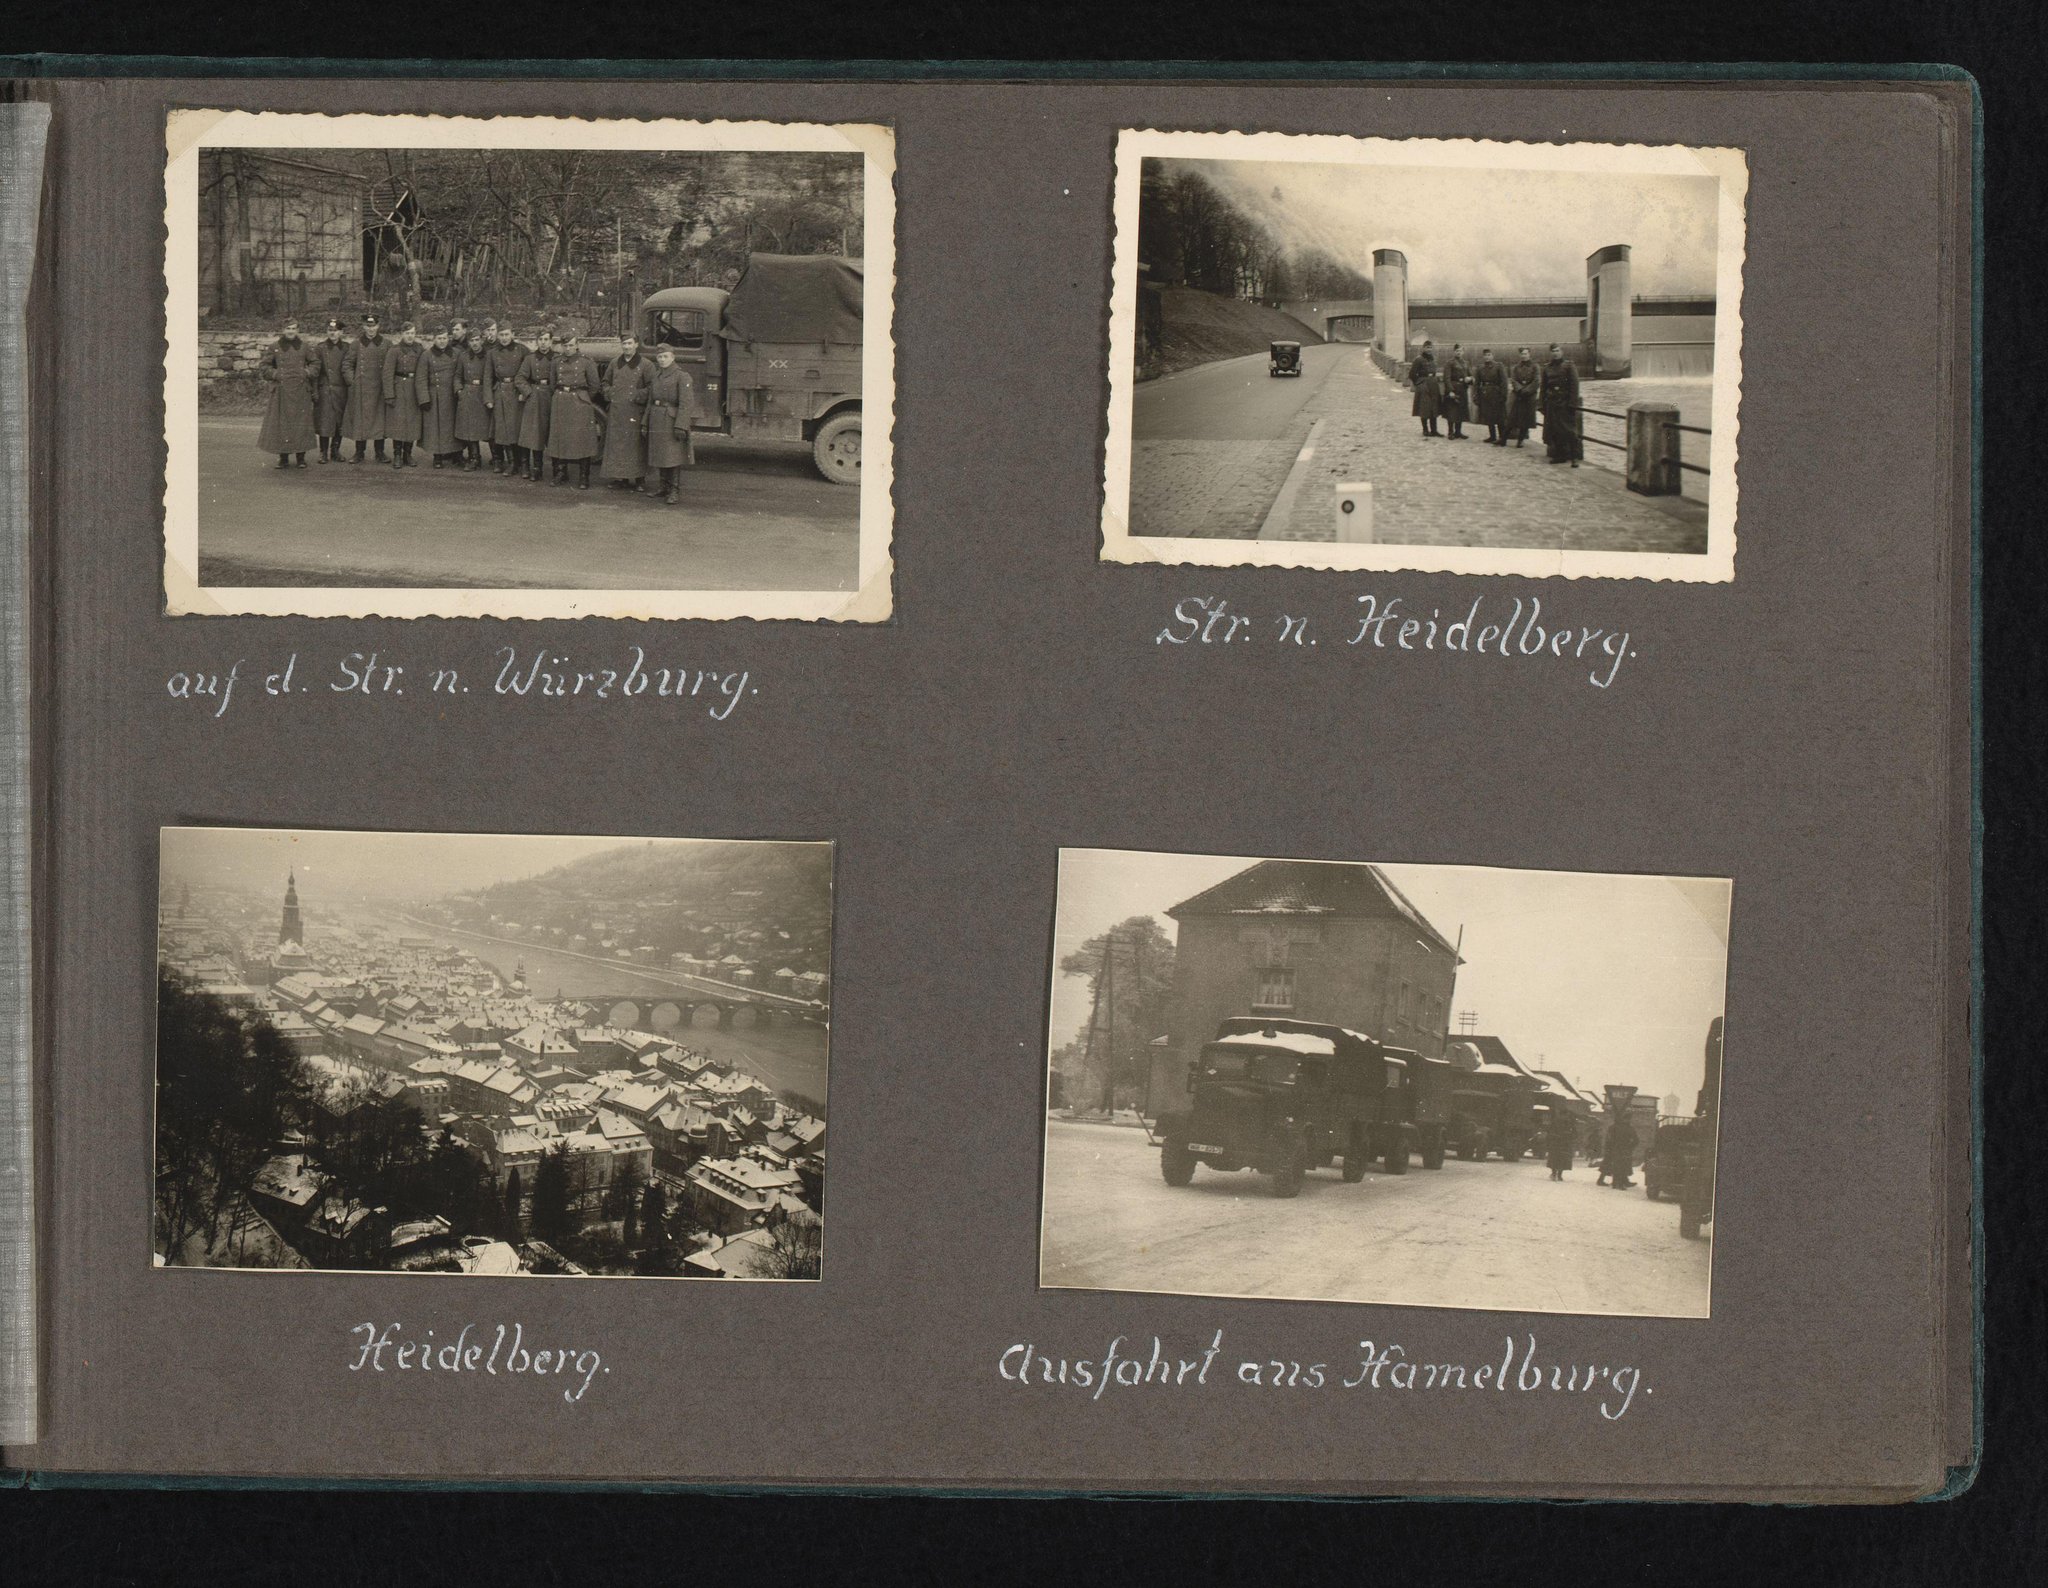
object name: album leaf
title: Duitse soldaten in Würzburg, Heidelberg en Hammelburg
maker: Anonymous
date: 1940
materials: cardboard, photographic support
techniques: gelatin silver print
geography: germany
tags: army 'en route', troop movements, transportation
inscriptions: inscription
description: Albumblad met vier fotos van Duitse soldaten in Würzburg, Heidelberg en Hammelburg. Onderdeel van het fotoalbum 'Kriegserinnerungen' 1940-1945.